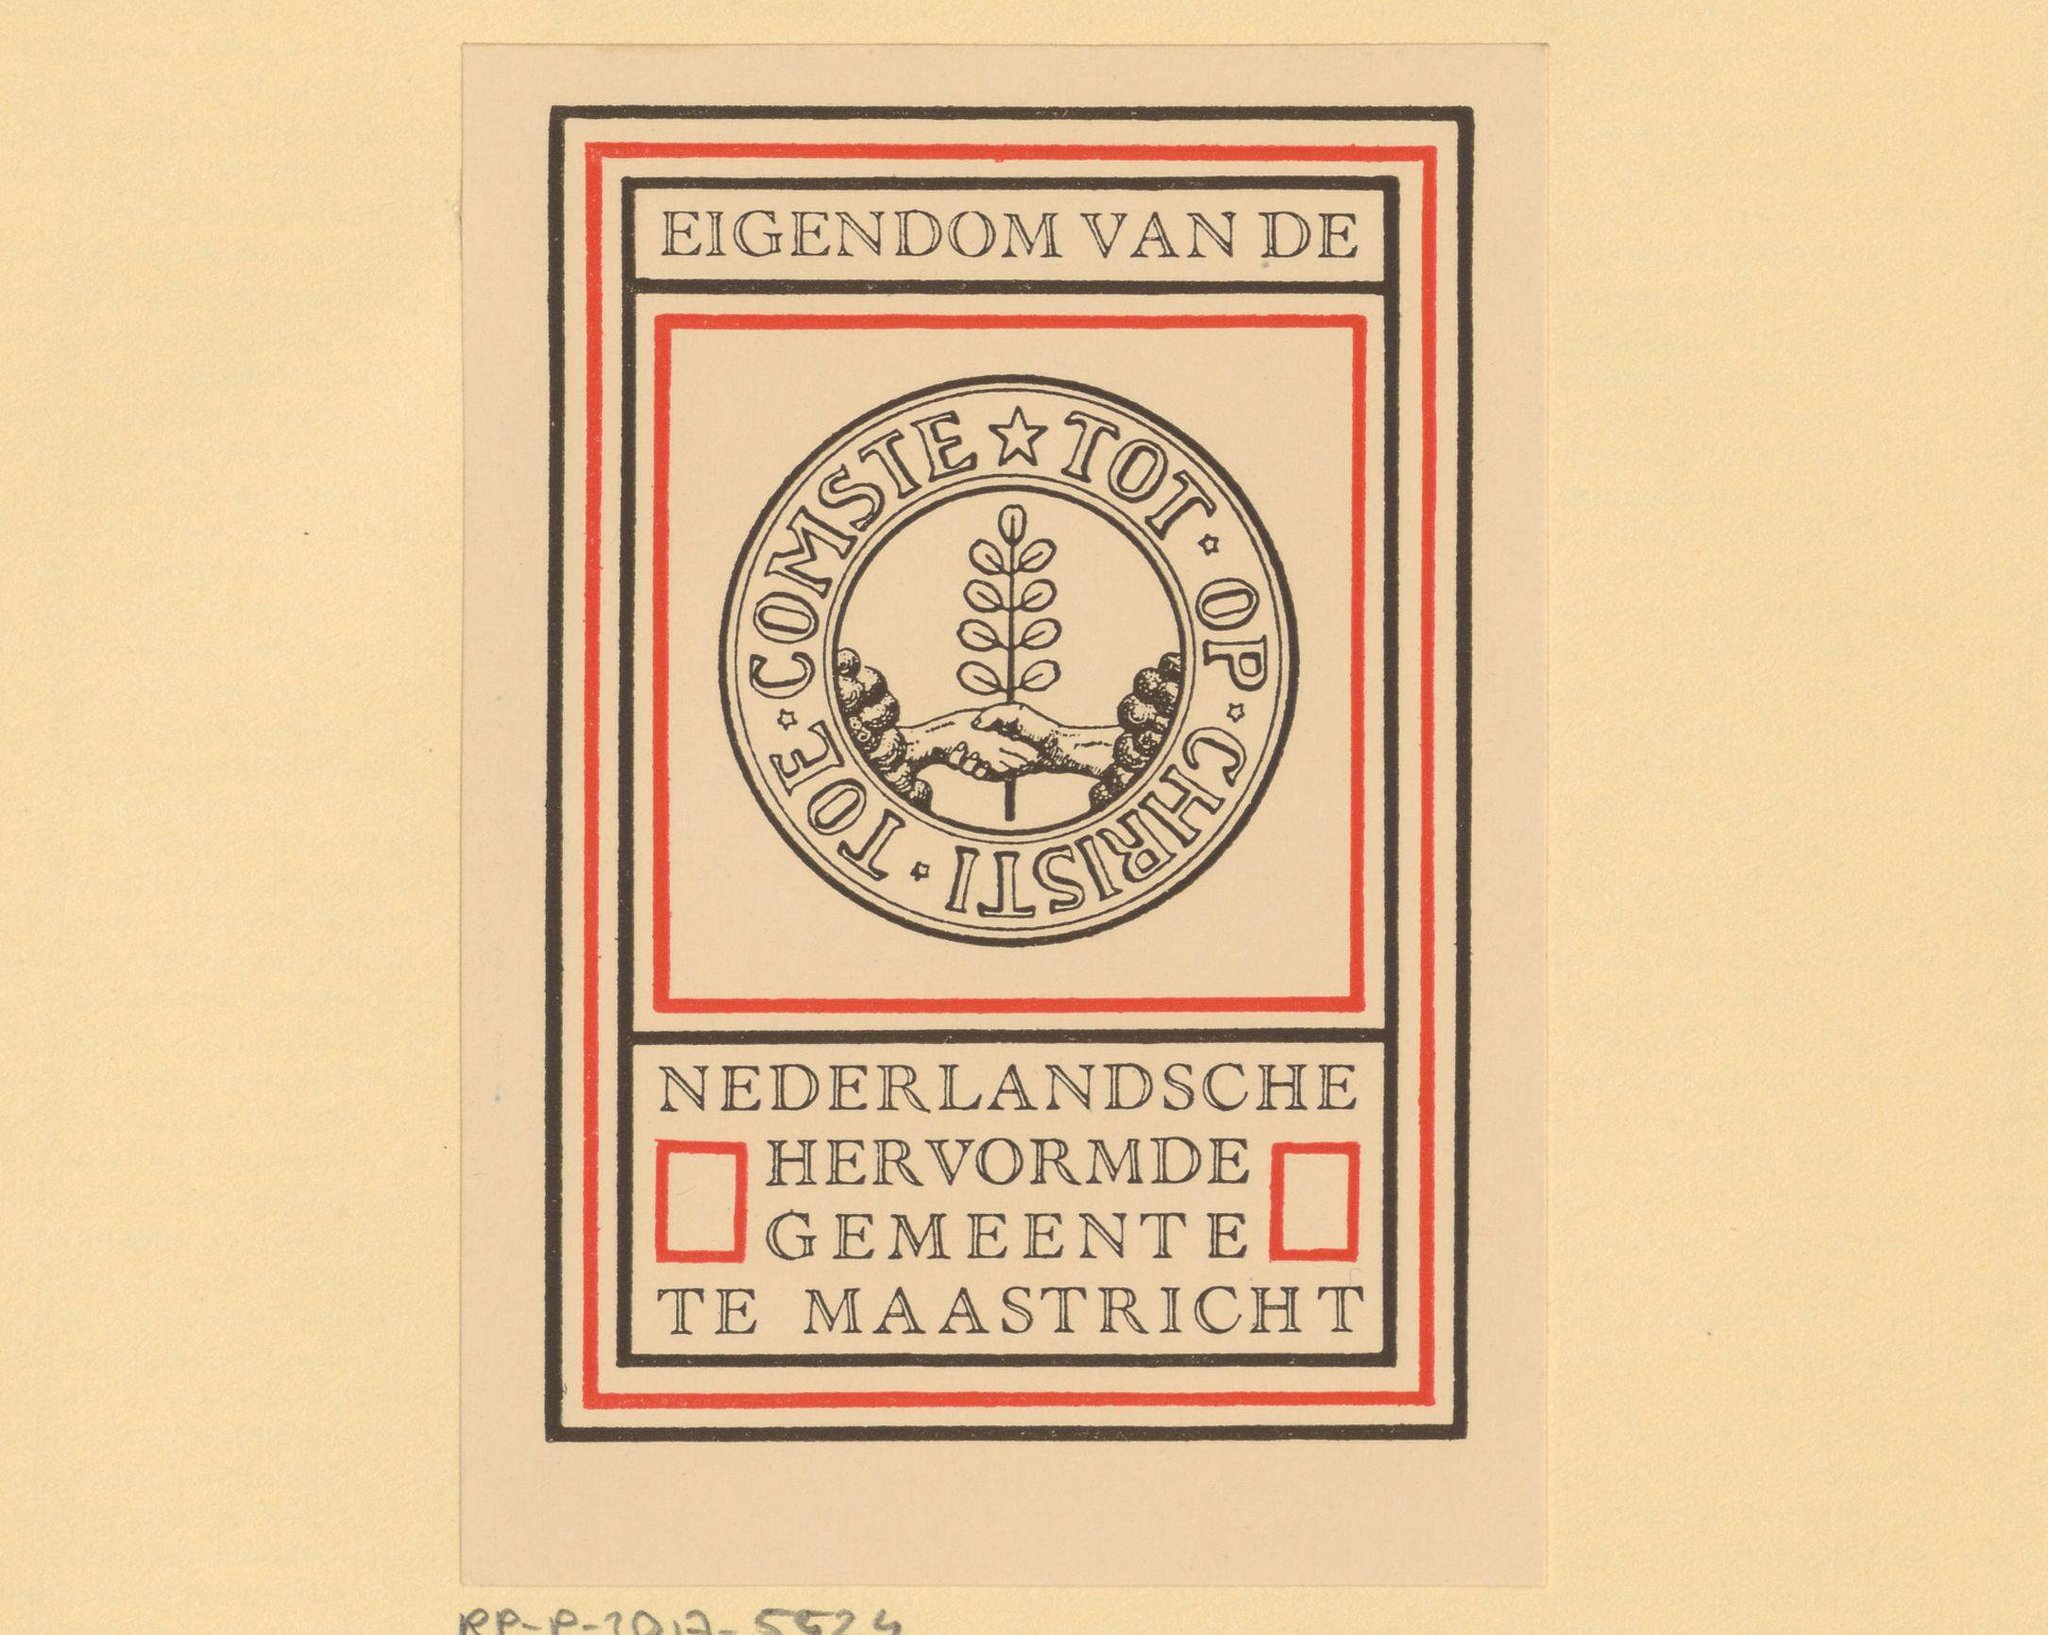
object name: bookplate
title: Ex libris van de Nederlandsche Hervormde Gemeente te Maastricht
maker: Anonymous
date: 1930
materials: paper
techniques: printing block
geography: netherlands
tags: shaking hands, 'dextrarum junctio', plants and herbs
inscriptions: inscription: ‘2584 / Nypels '30’